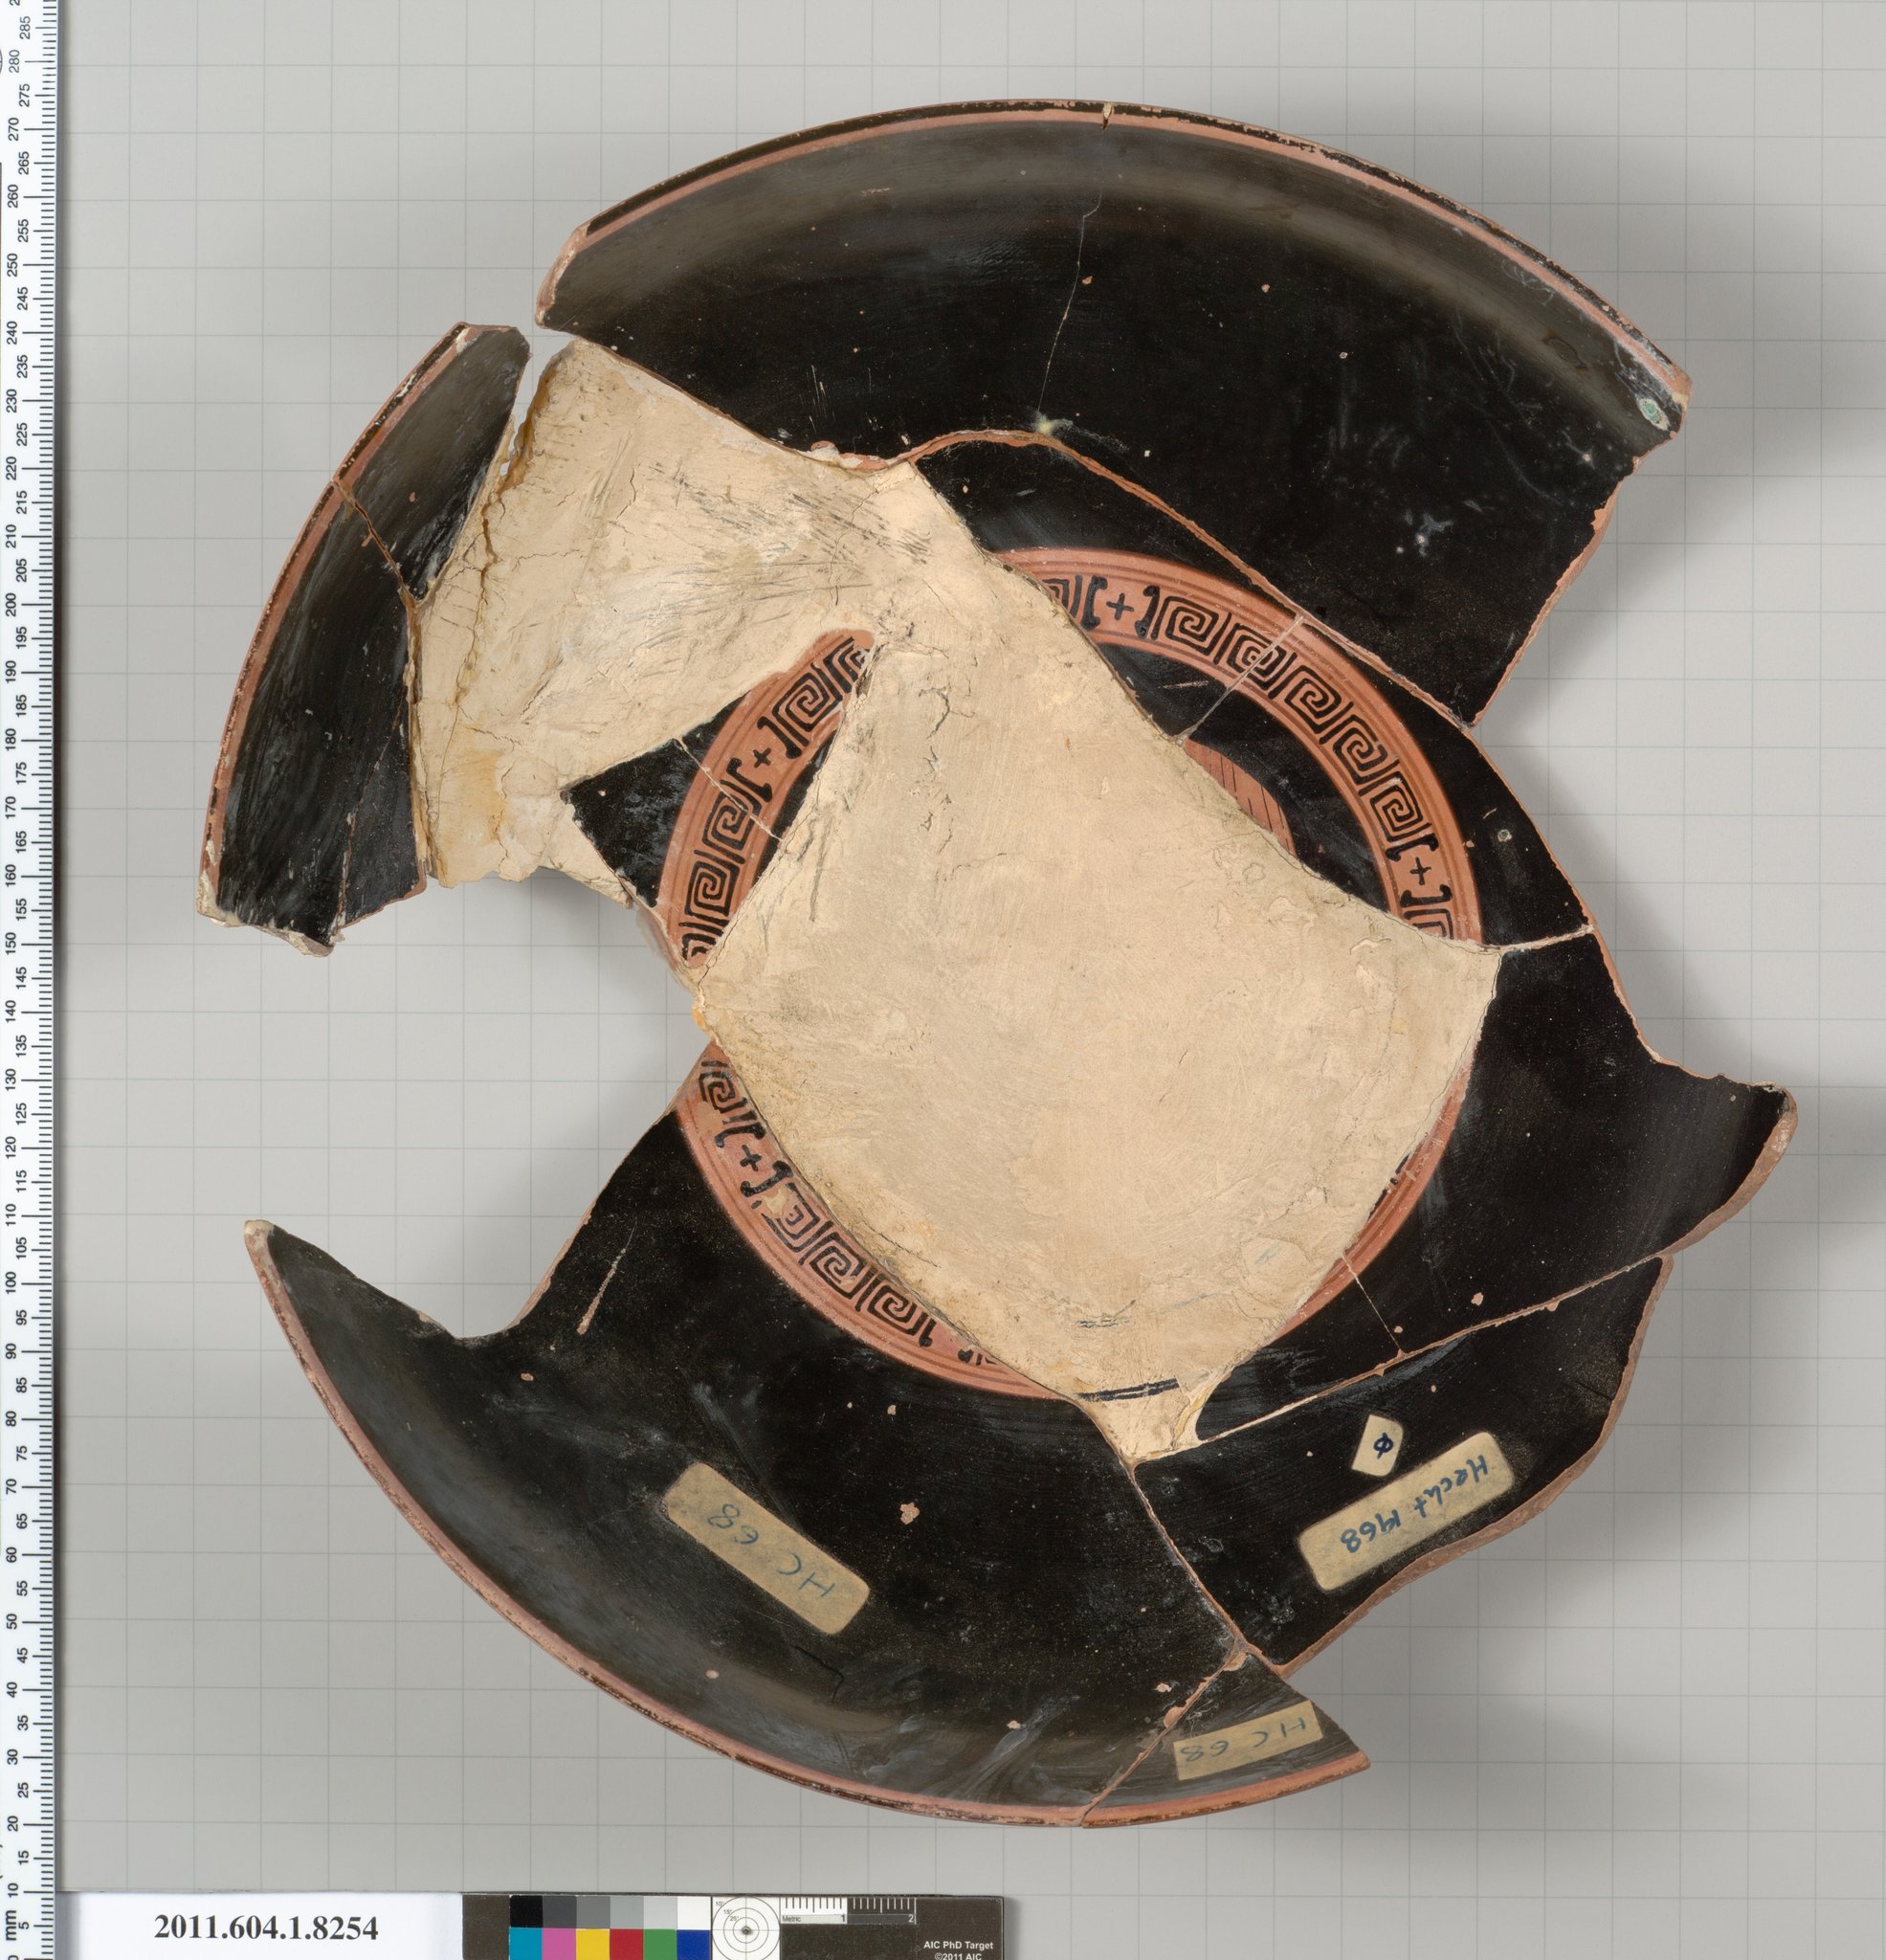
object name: kylix fragment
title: Terracotta fragment of a kylix (drinking cup)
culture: greek, attic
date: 460-450 BCE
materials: terracotta